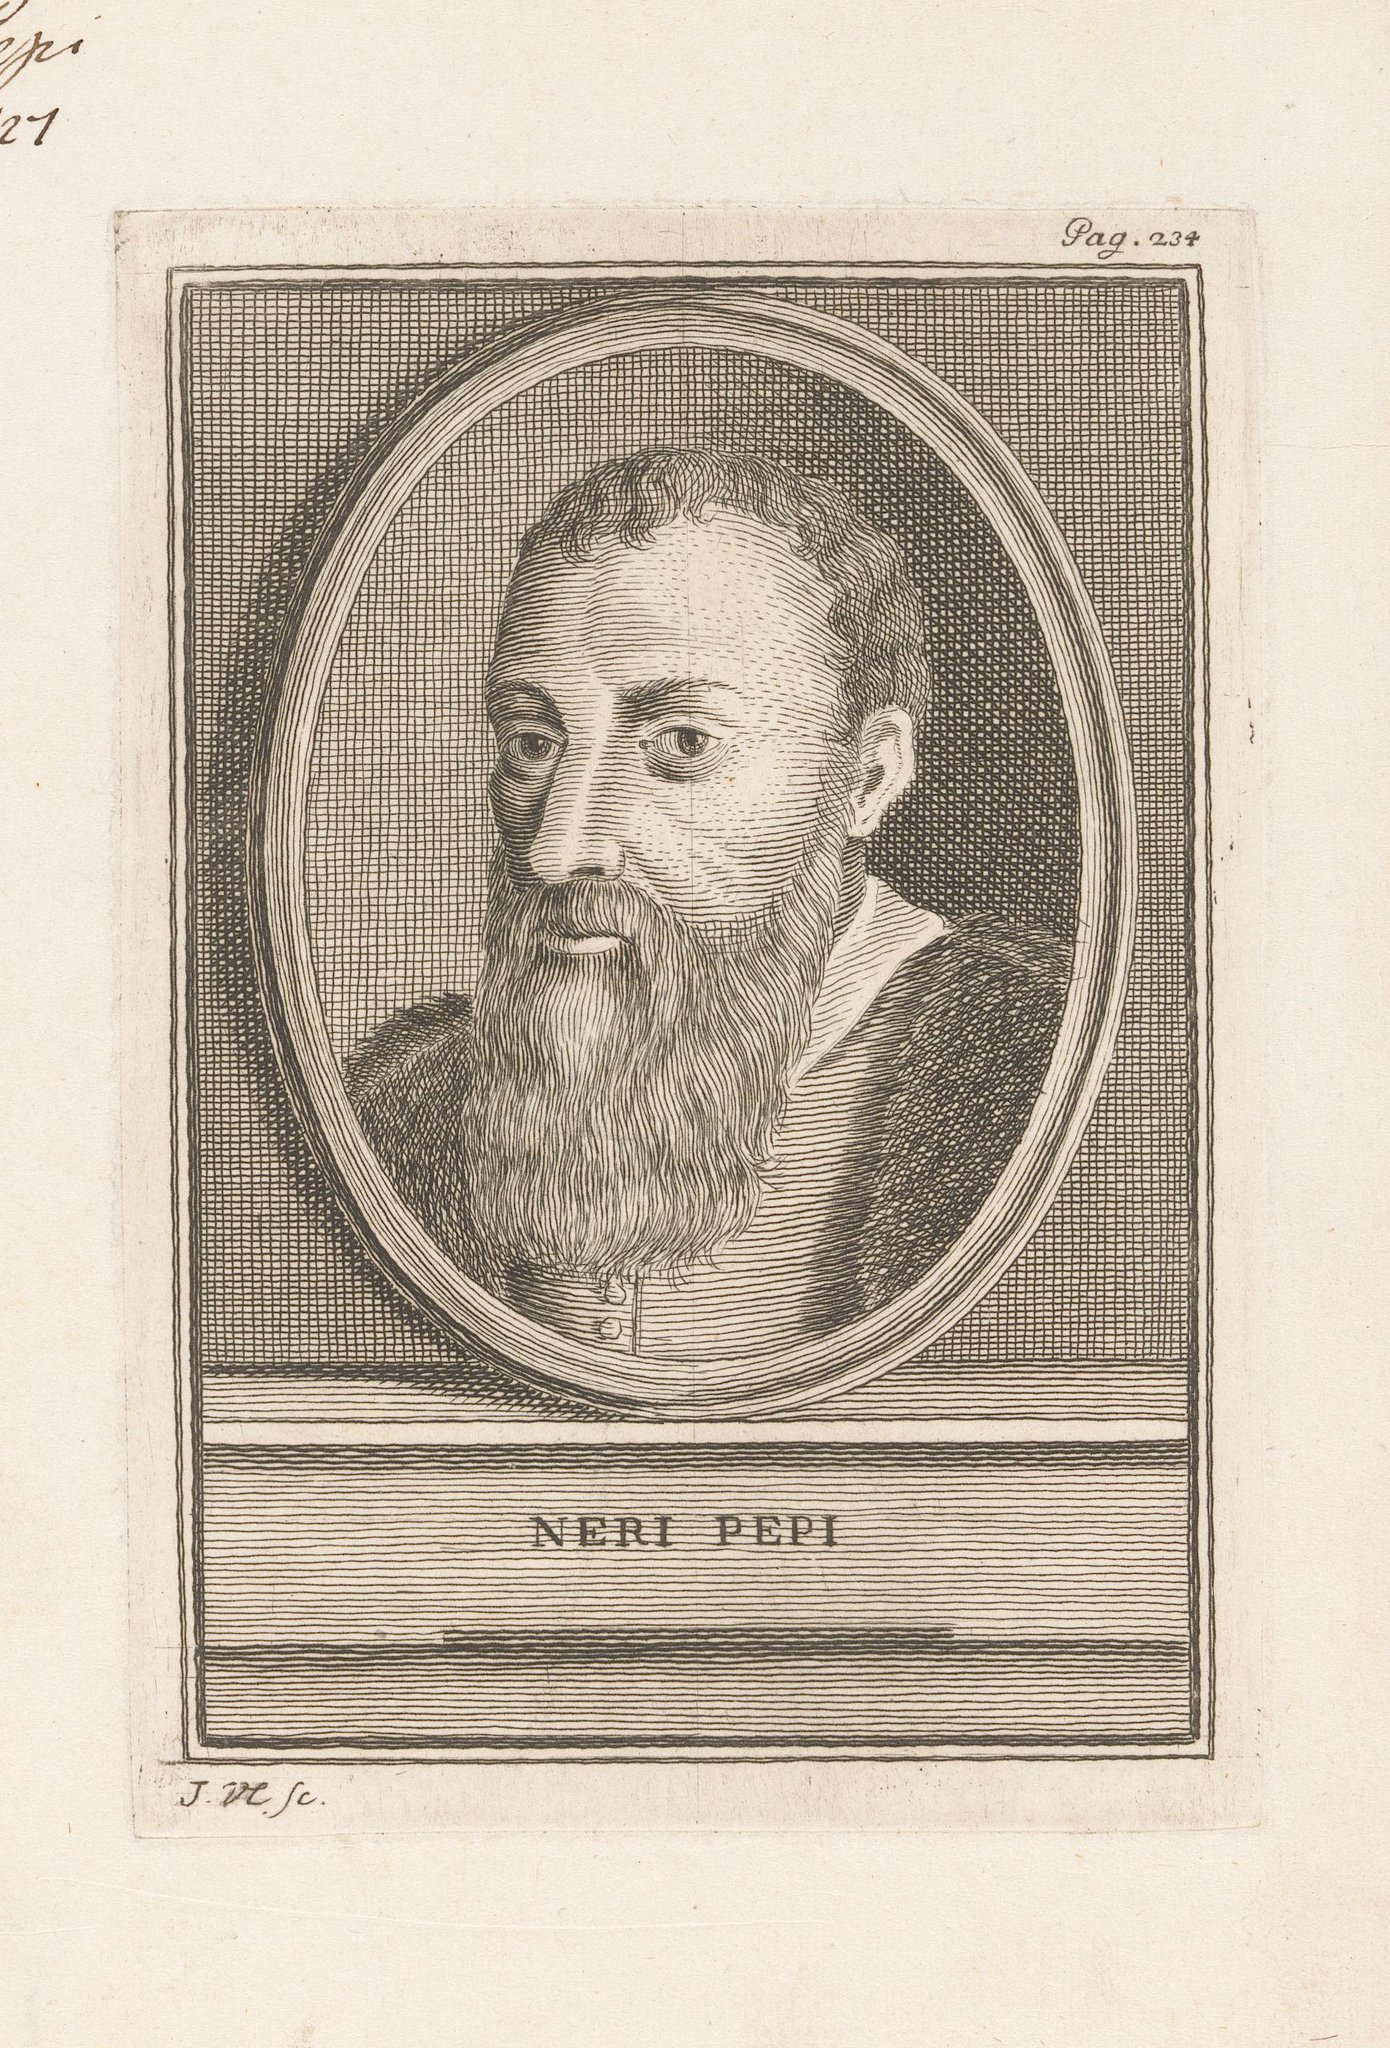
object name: print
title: Portretten van schrijvers die liederen schreven voor Lorenzo de'Medici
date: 1750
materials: paper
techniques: engraving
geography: italy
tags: historical persons, portrait of a writer, writer, poet, author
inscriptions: collector's mark: Lugt 2228, inscription: ‘Pepi / 4127’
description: Prent gebruikt voor Grazzini, Anton Francesco. Tutti i trionfi, carri, mascherate o canti carnascialeschi andati per Firenze dal tempo del Magnifico Lorenzo de' Medici fino all' anno 1559 : in questa seconda edizione corretti, con diversi MSS. collazionati, delle loro varie lezioni arricchiti, notabilmente accresciuti, e co' ritratti di ciascun poeta adornate. Lucca: Cosmopoli, 1750.